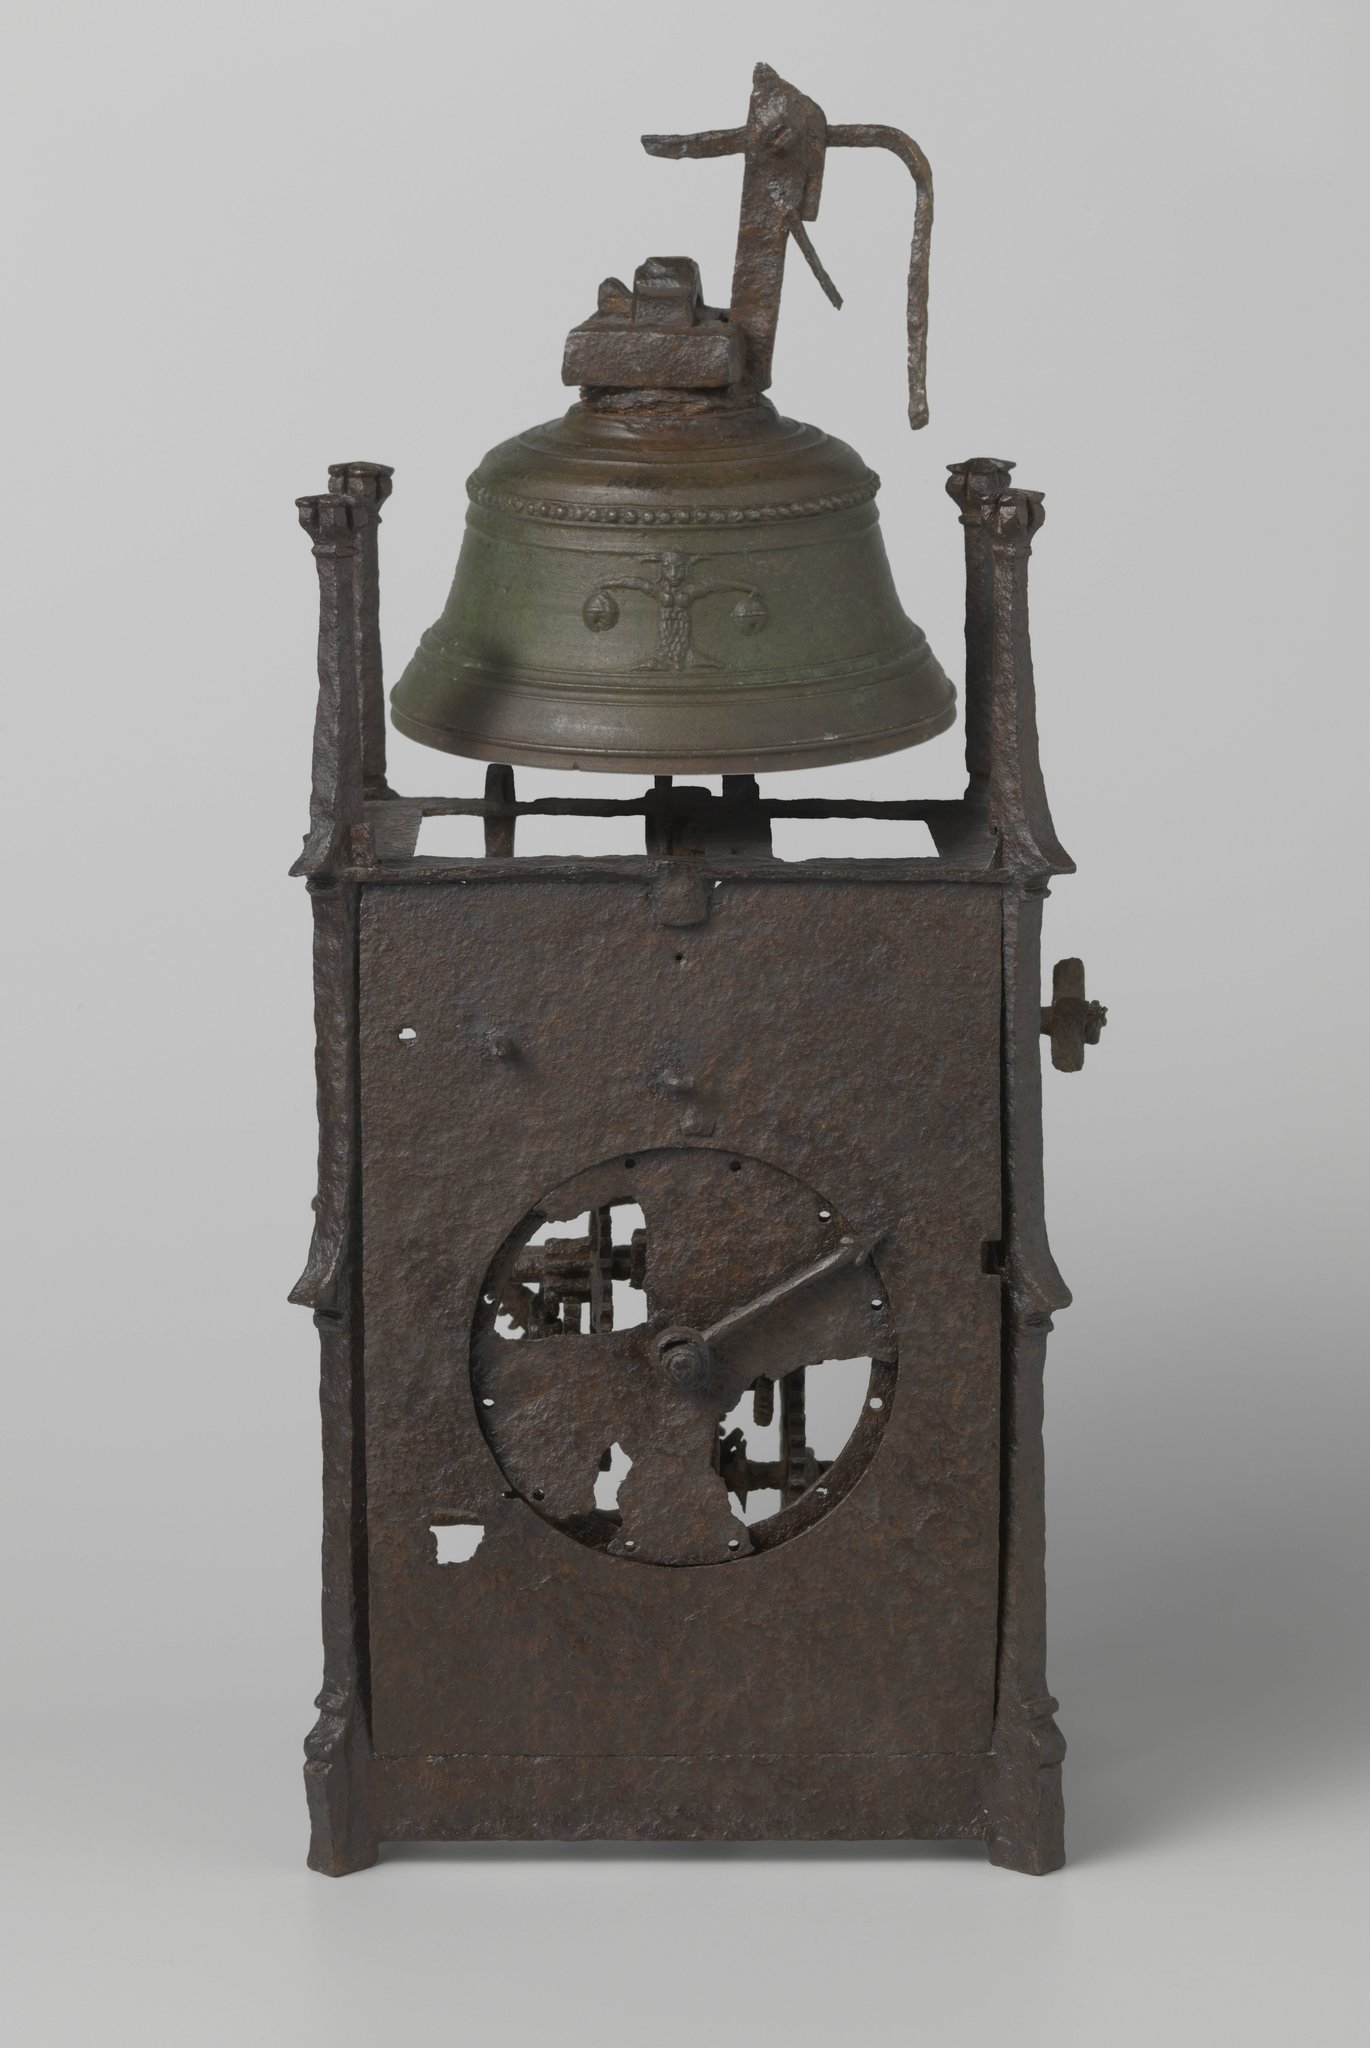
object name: jingle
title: Clock and gunpowder horn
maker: Anonymous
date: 1590-1596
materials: copper, iron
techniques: forging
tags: willem barendsz., amsterdam, jacob van heemskerck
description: This clock was originally intended as merchandise for sale or as a gift. It was hung up in the ‘Save House’ as the only means of providing a sense of time during the long, polar nights. On 3 December 1596, it froze. Barentsz and Van Heemskerck shoved a parting letter into the gunpowder horn when they left. Three centuries later, the horn was rediscovered with the letter still inside. The letter cannot be exhibited due to its fragility.